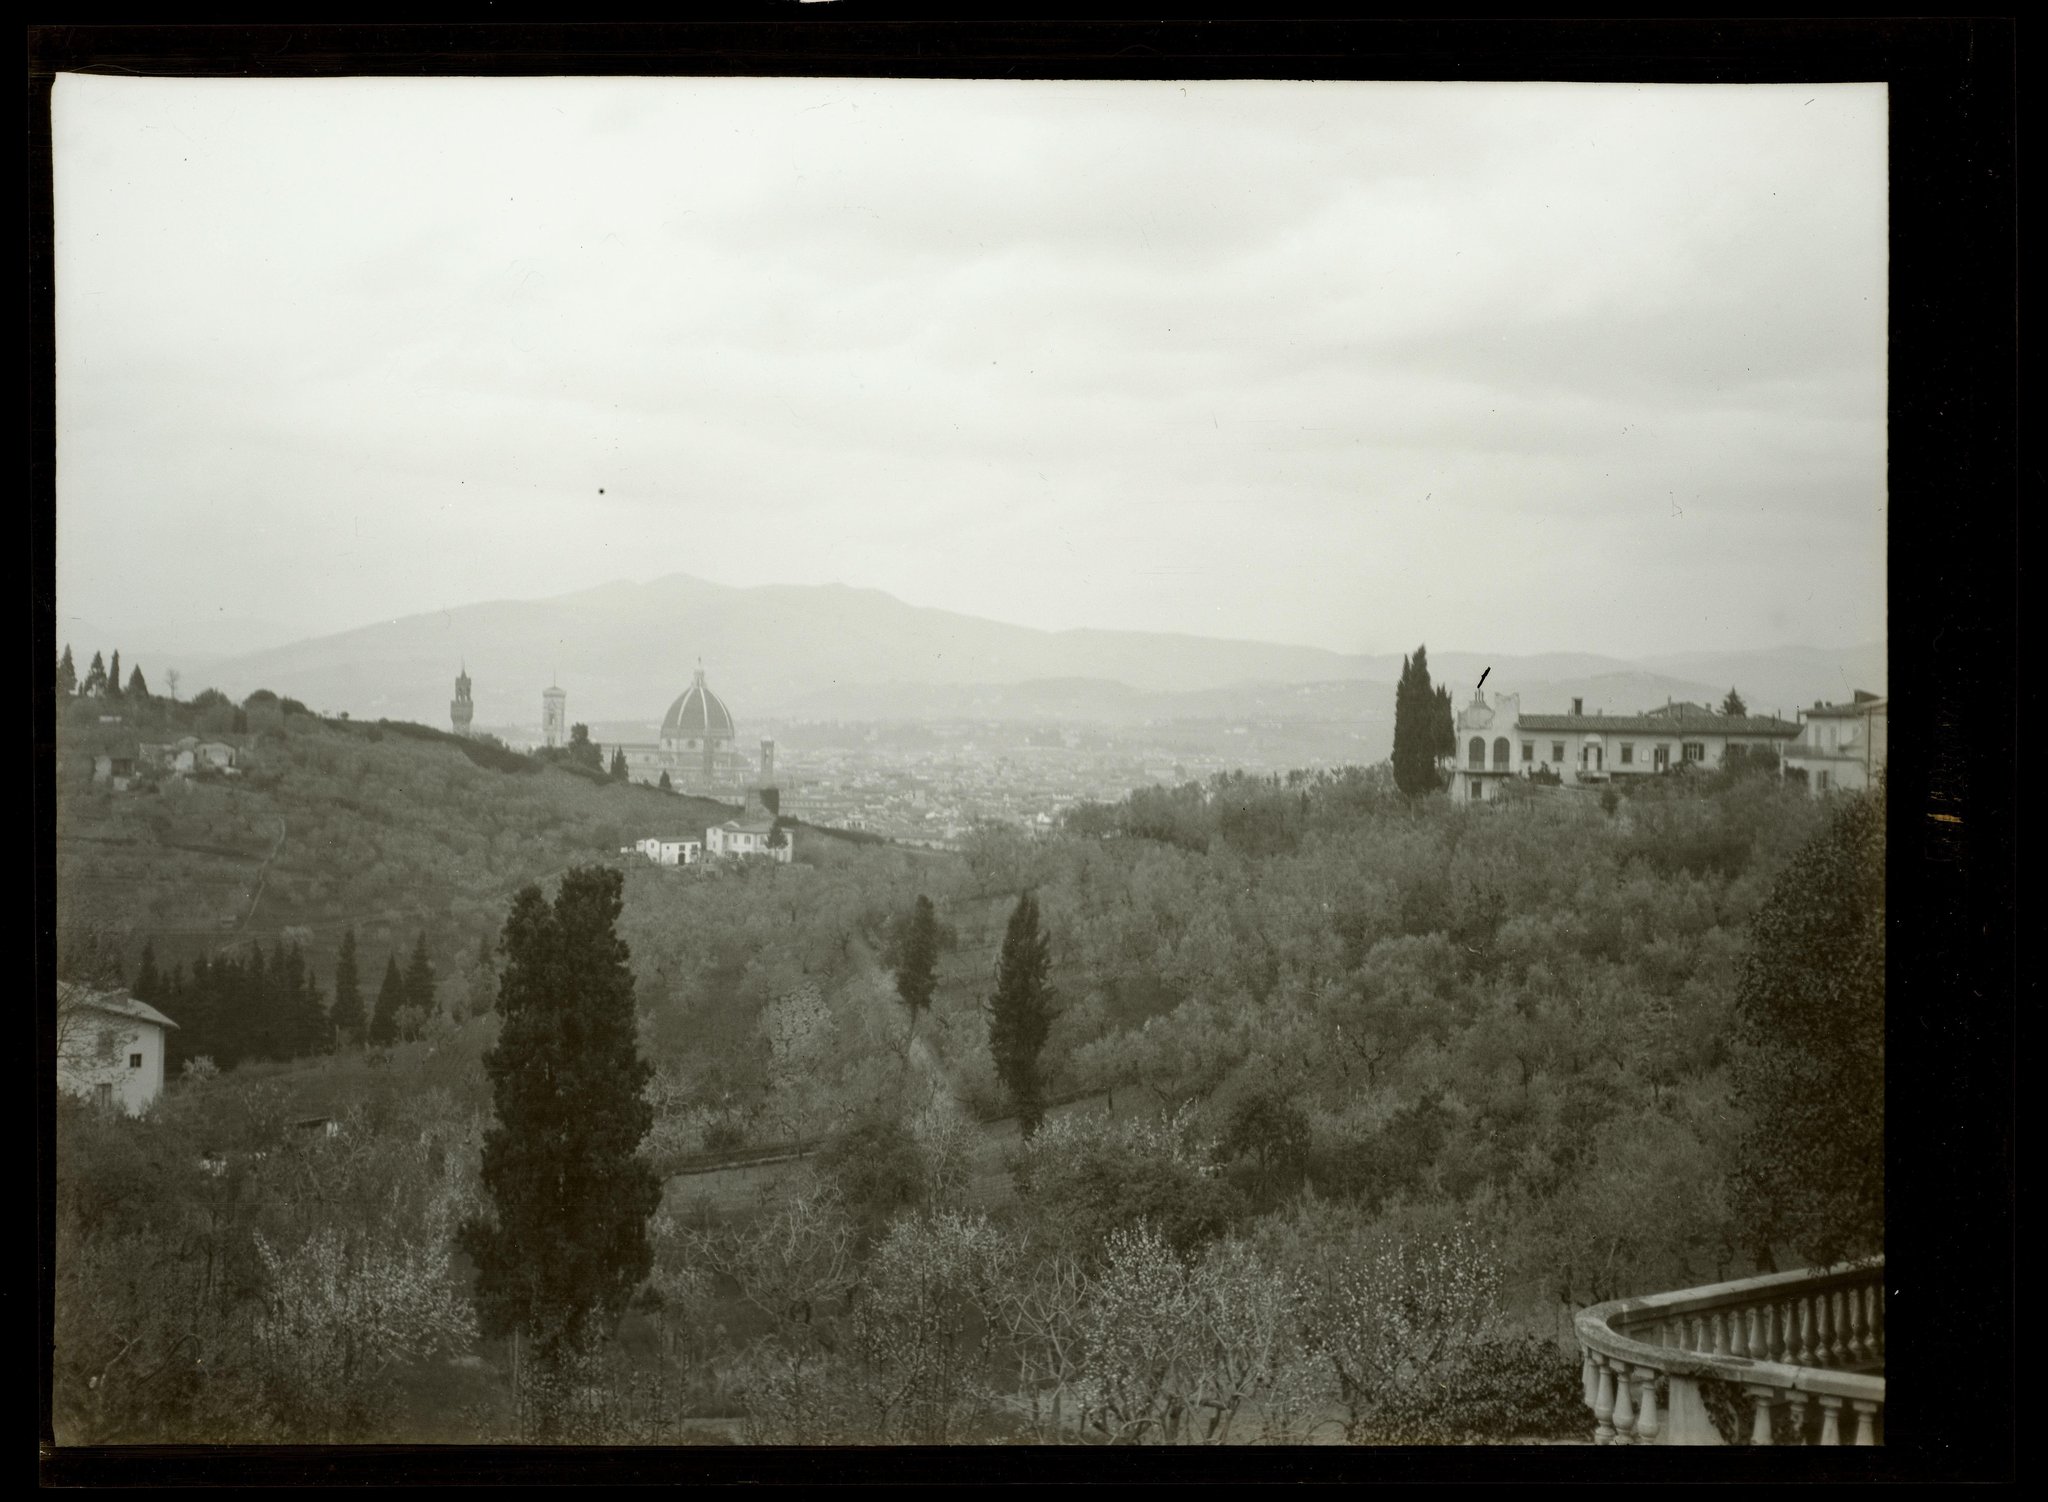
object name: negative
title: Filmnegatief met opname van Florence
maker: Anonymous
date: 1907-1935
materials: film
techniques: gelatin silver negative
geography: florence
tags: florence